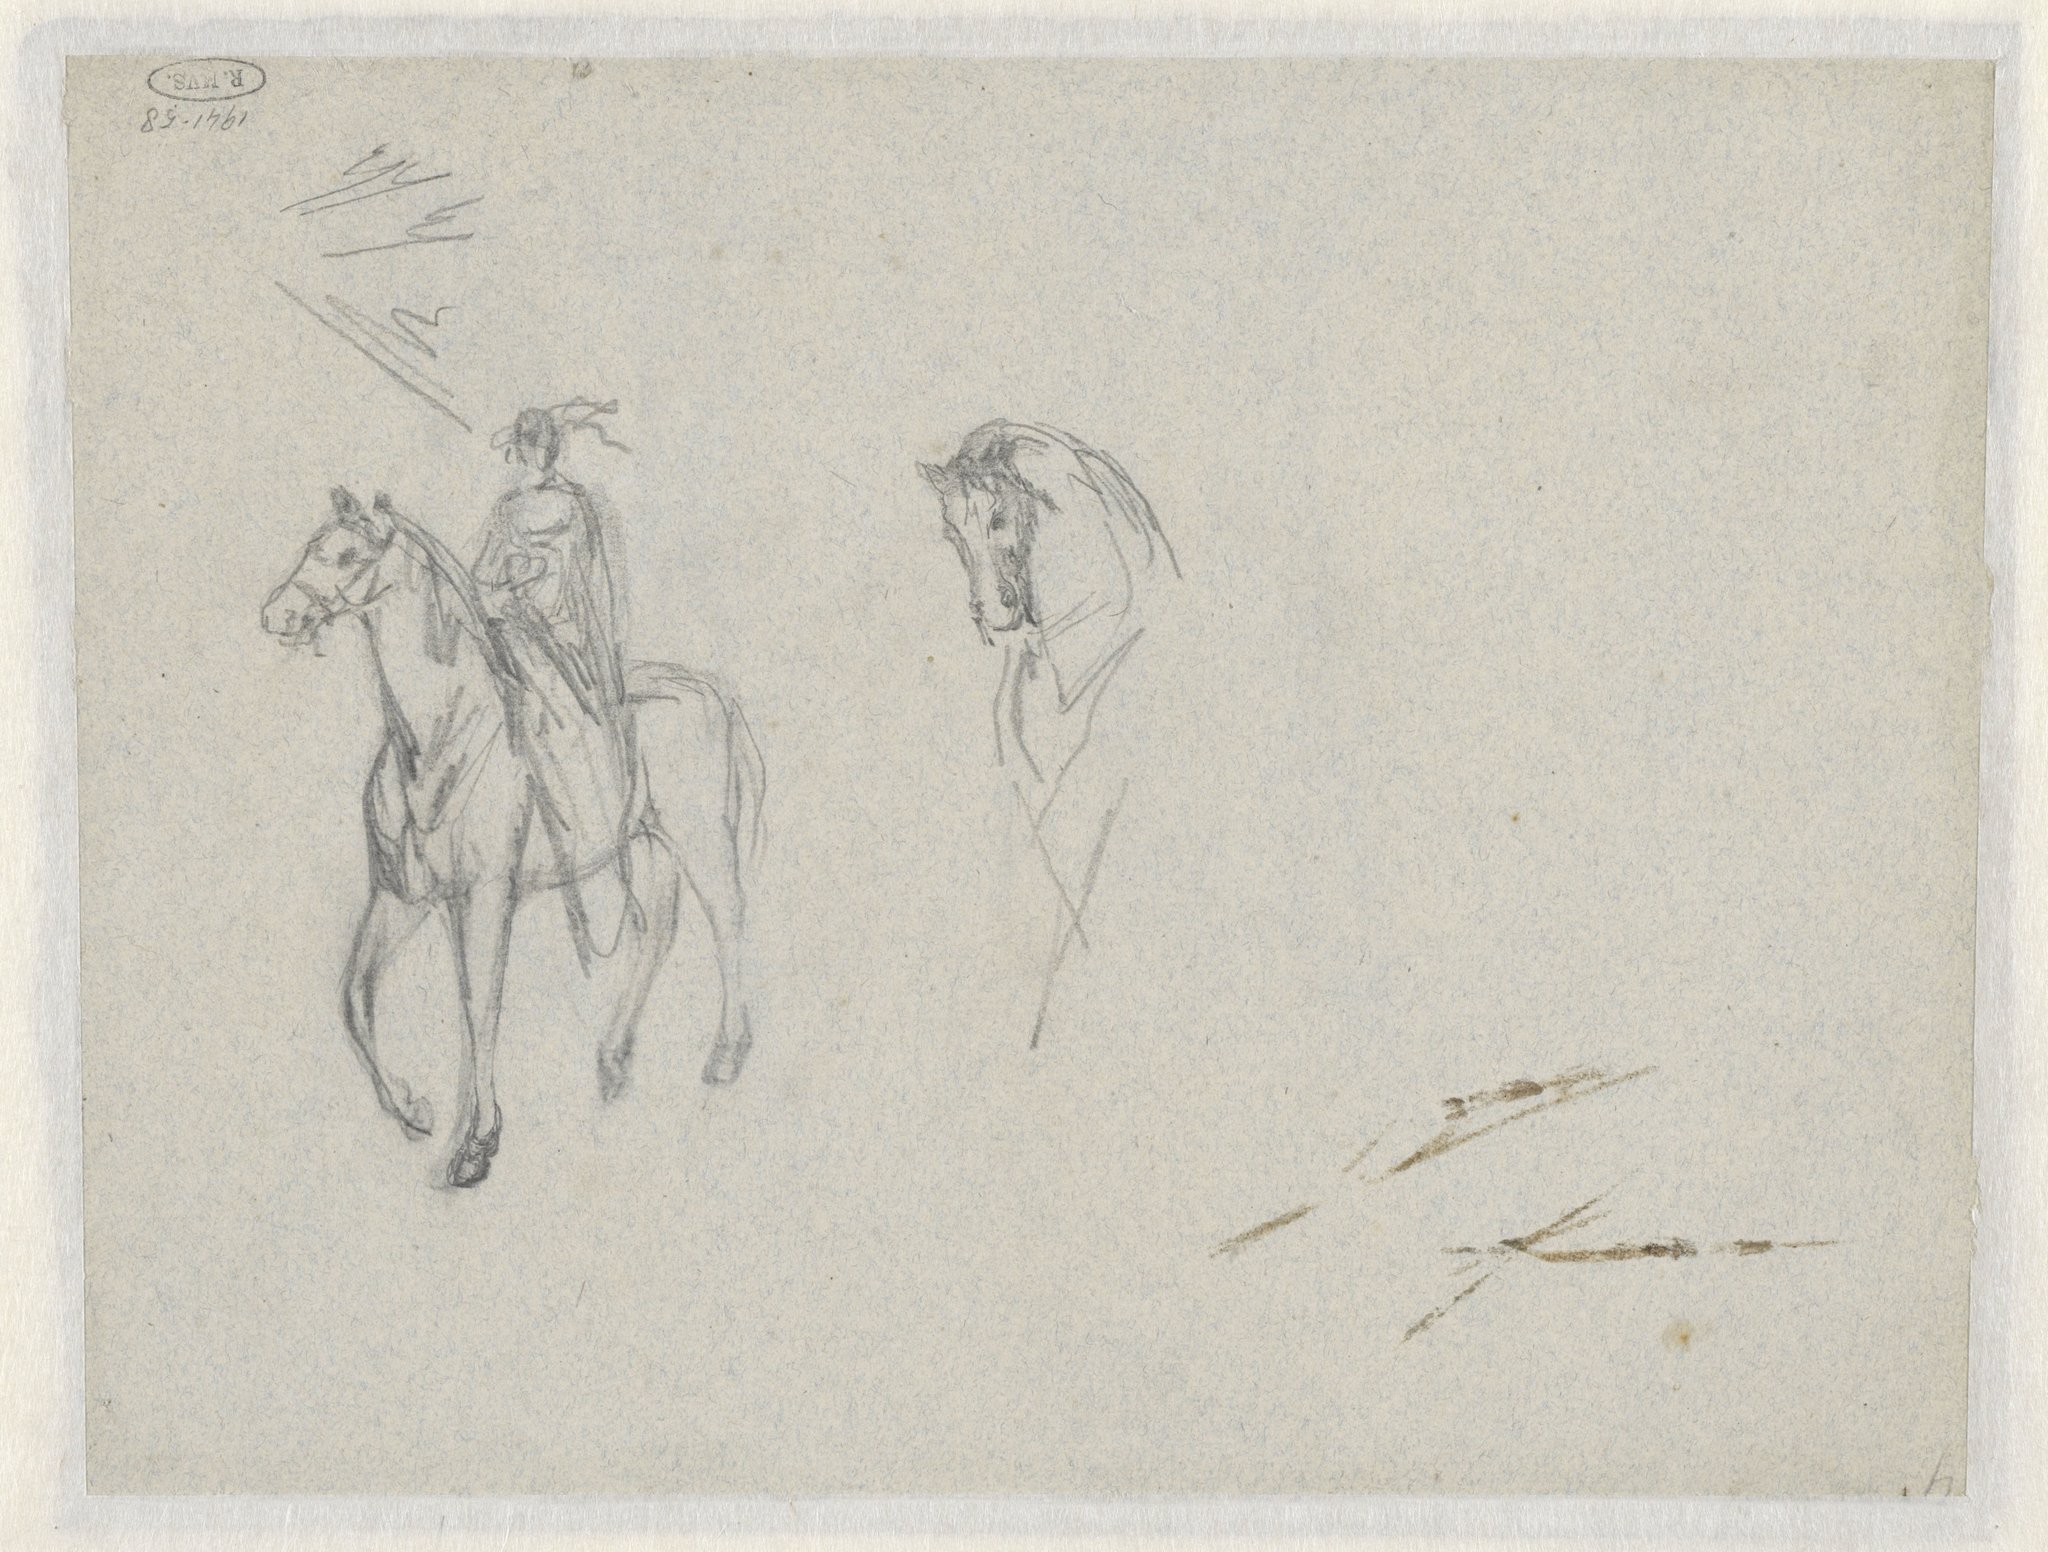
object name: drawing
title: Twee studies van een paard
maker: jan kuyper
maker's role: draughtsman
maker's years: 1845-1912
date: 1855-1912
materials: chalk, paper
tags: horse